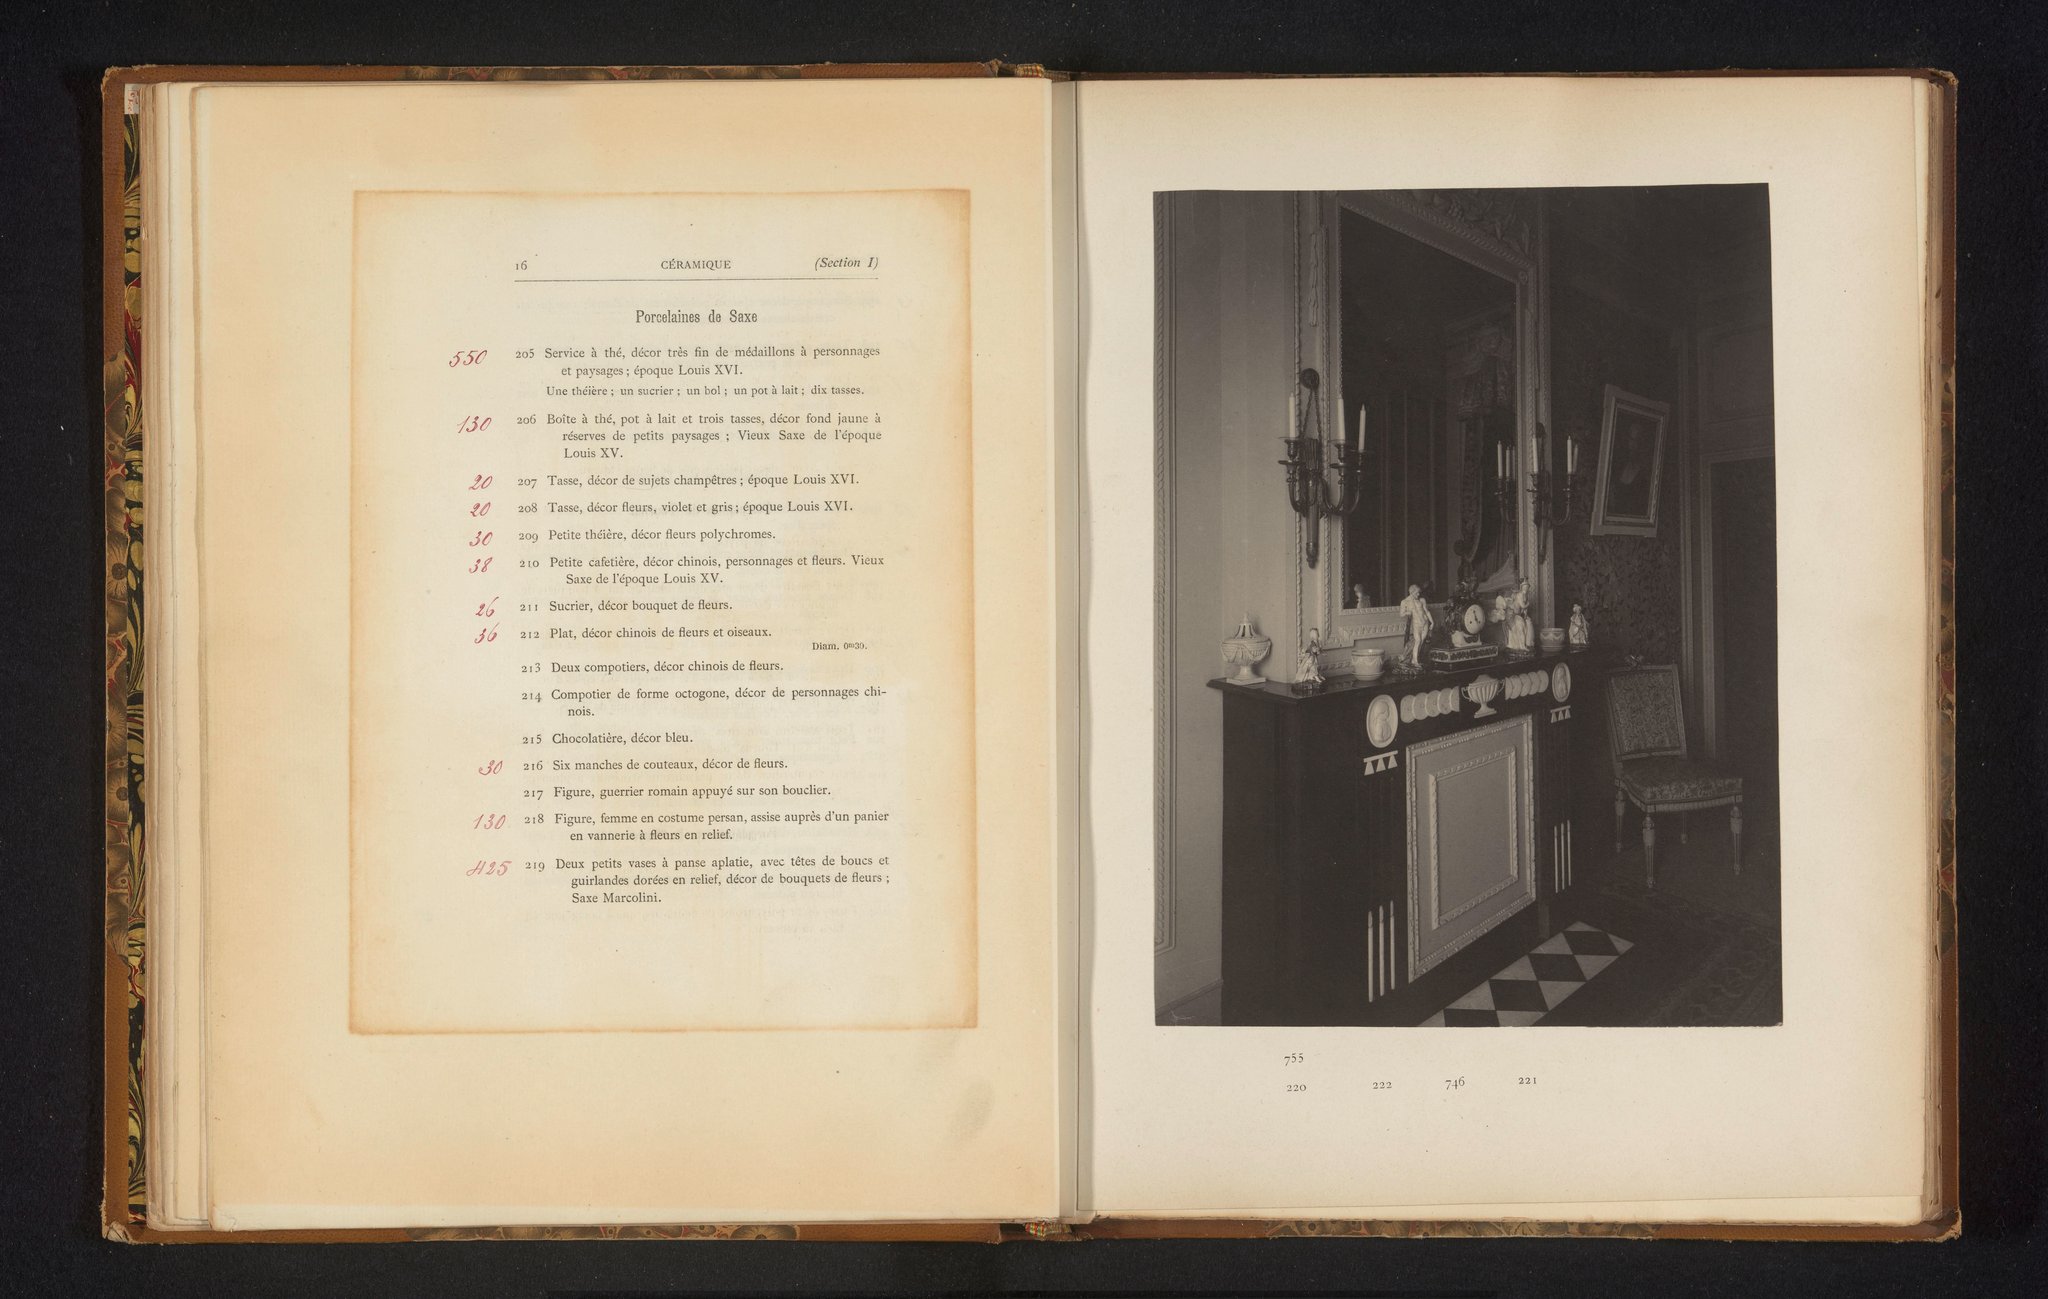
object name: photograph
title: Kamer in het huis van Antonin Terme met zijn collectie antiquiteiten, beeld van hercules, klok en kandelaren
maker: Anonymous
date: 1880-1885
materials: photographic support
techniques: platinum process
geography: liège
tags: art collection, art gallery, interior of the house